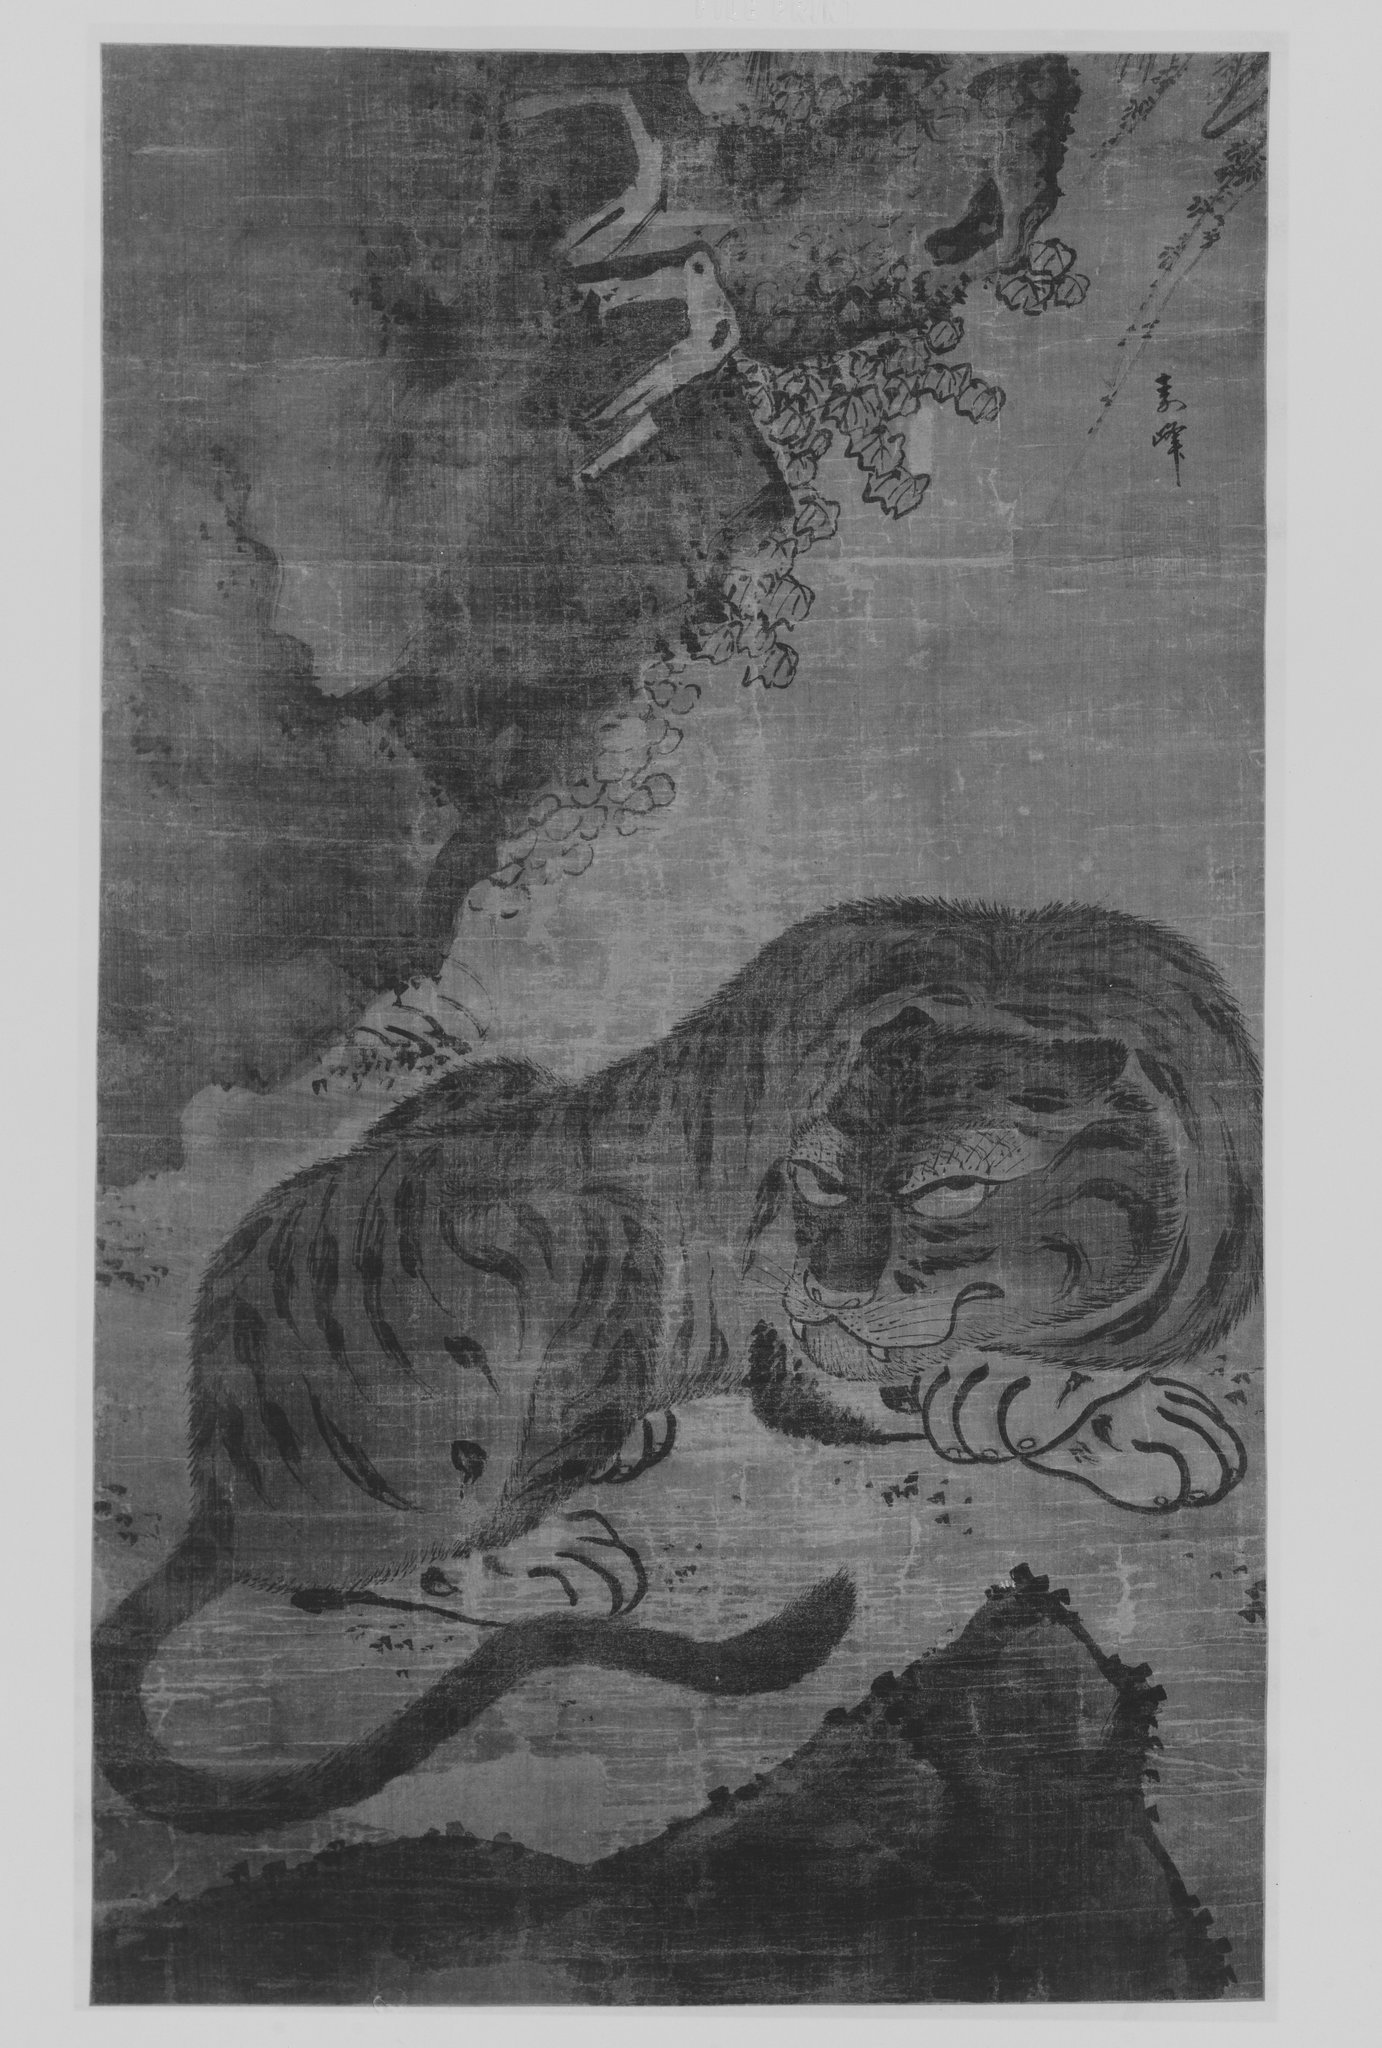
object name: hanging scroll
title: Tiger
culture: chinese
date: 1368-1644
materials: ink, silk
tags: tigers